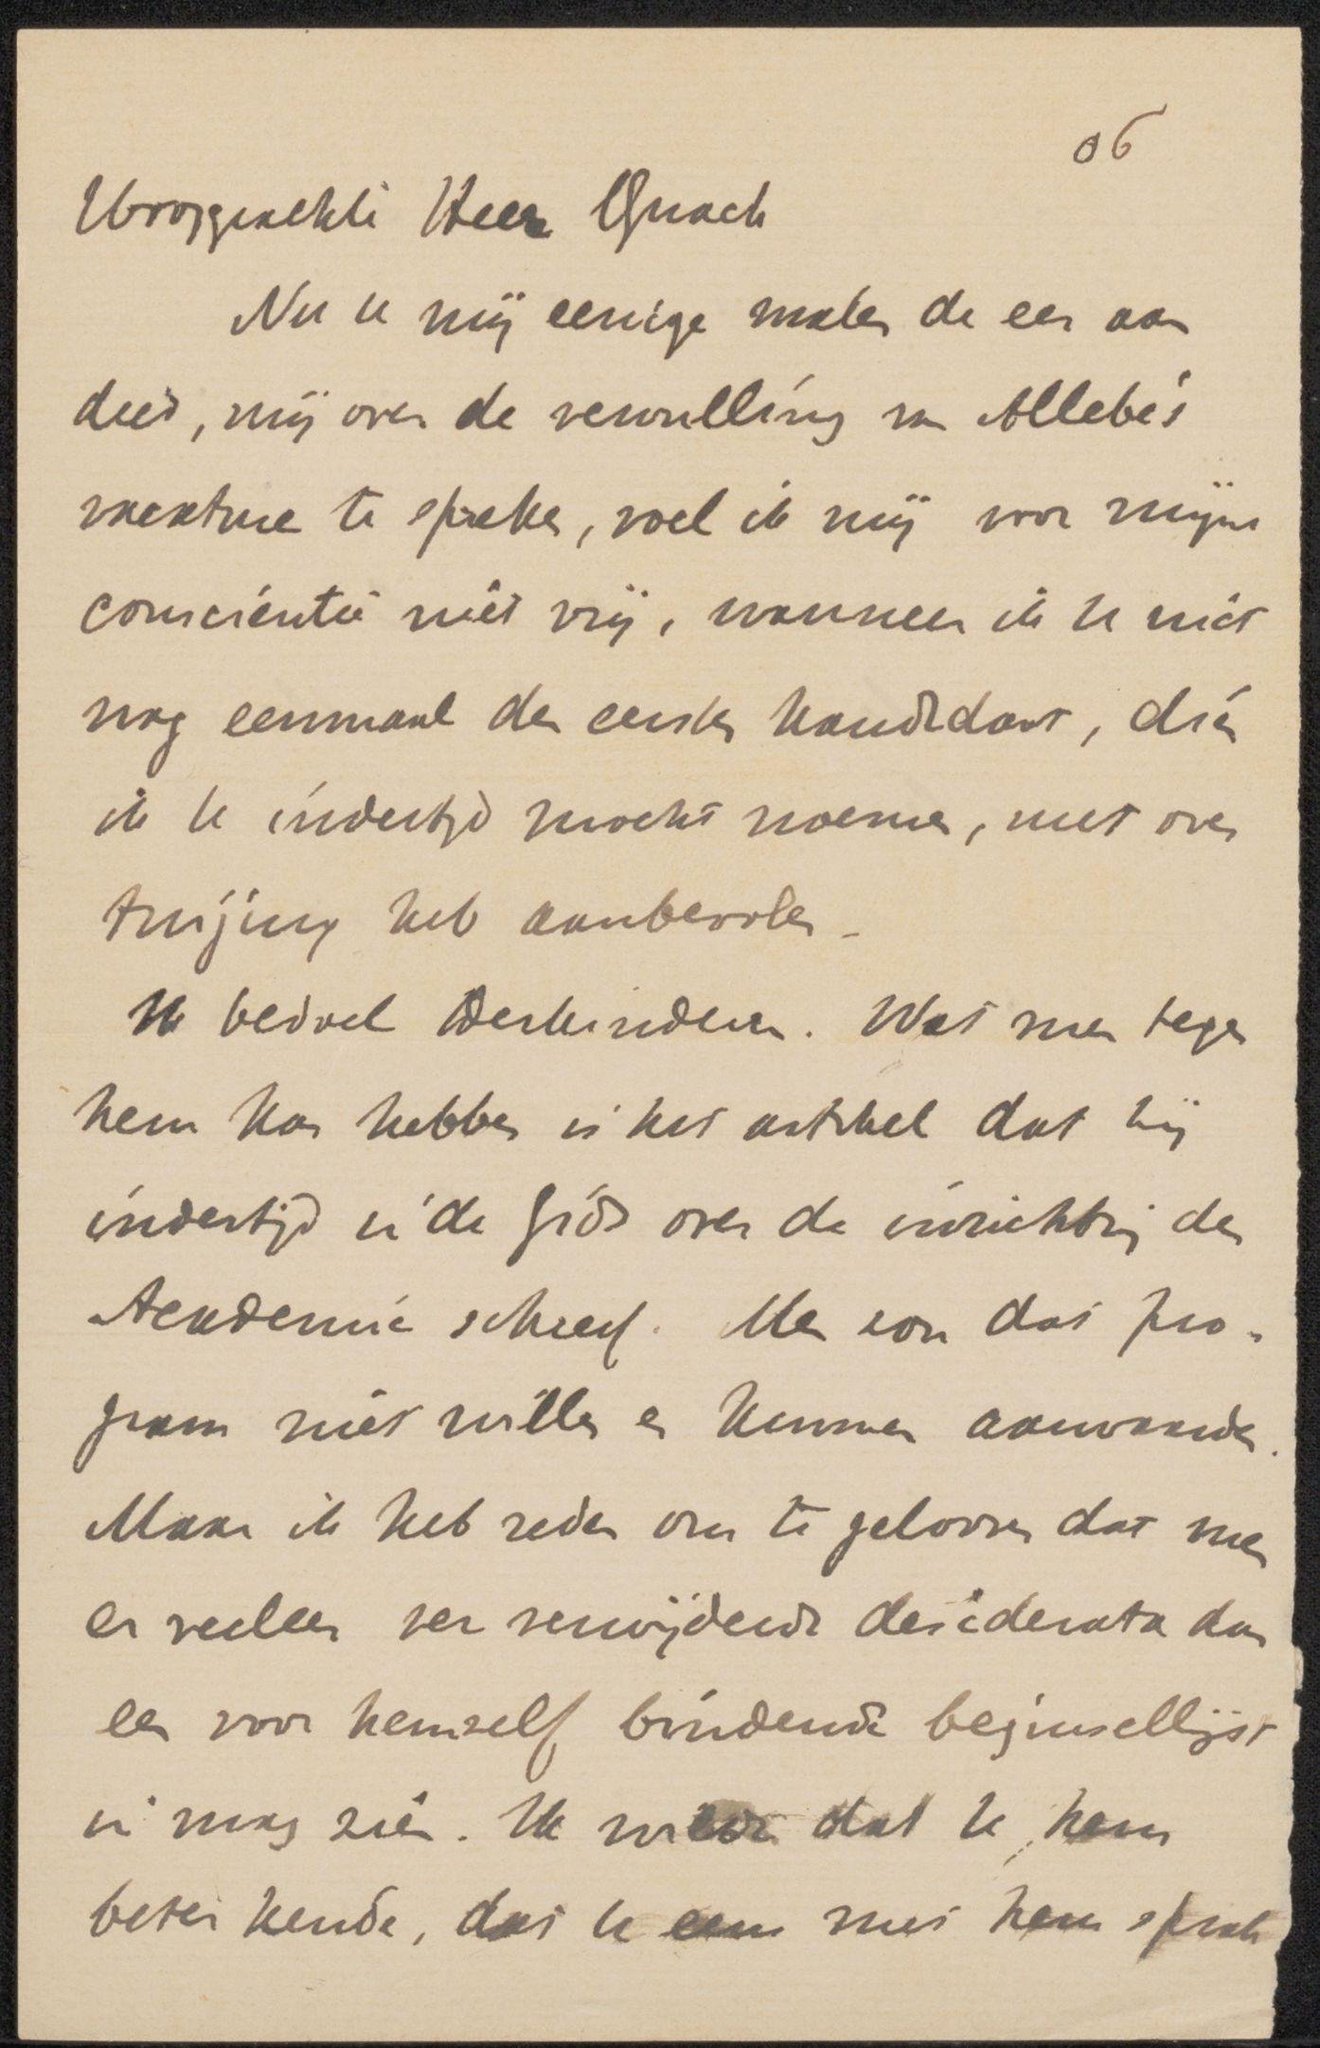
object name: letter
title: Brief aan Hendrick Peter Godfried Quack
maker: jan veth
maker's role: designer, draughtsman, painter, print maker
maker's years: 1864-1925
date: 1874-1917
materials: ink, paper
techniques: pen, writing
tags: august allebé, den bosch, antoon derkinderen, hendrick peter godfried quack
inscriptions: collector's mark: ‘RPK’, watermark